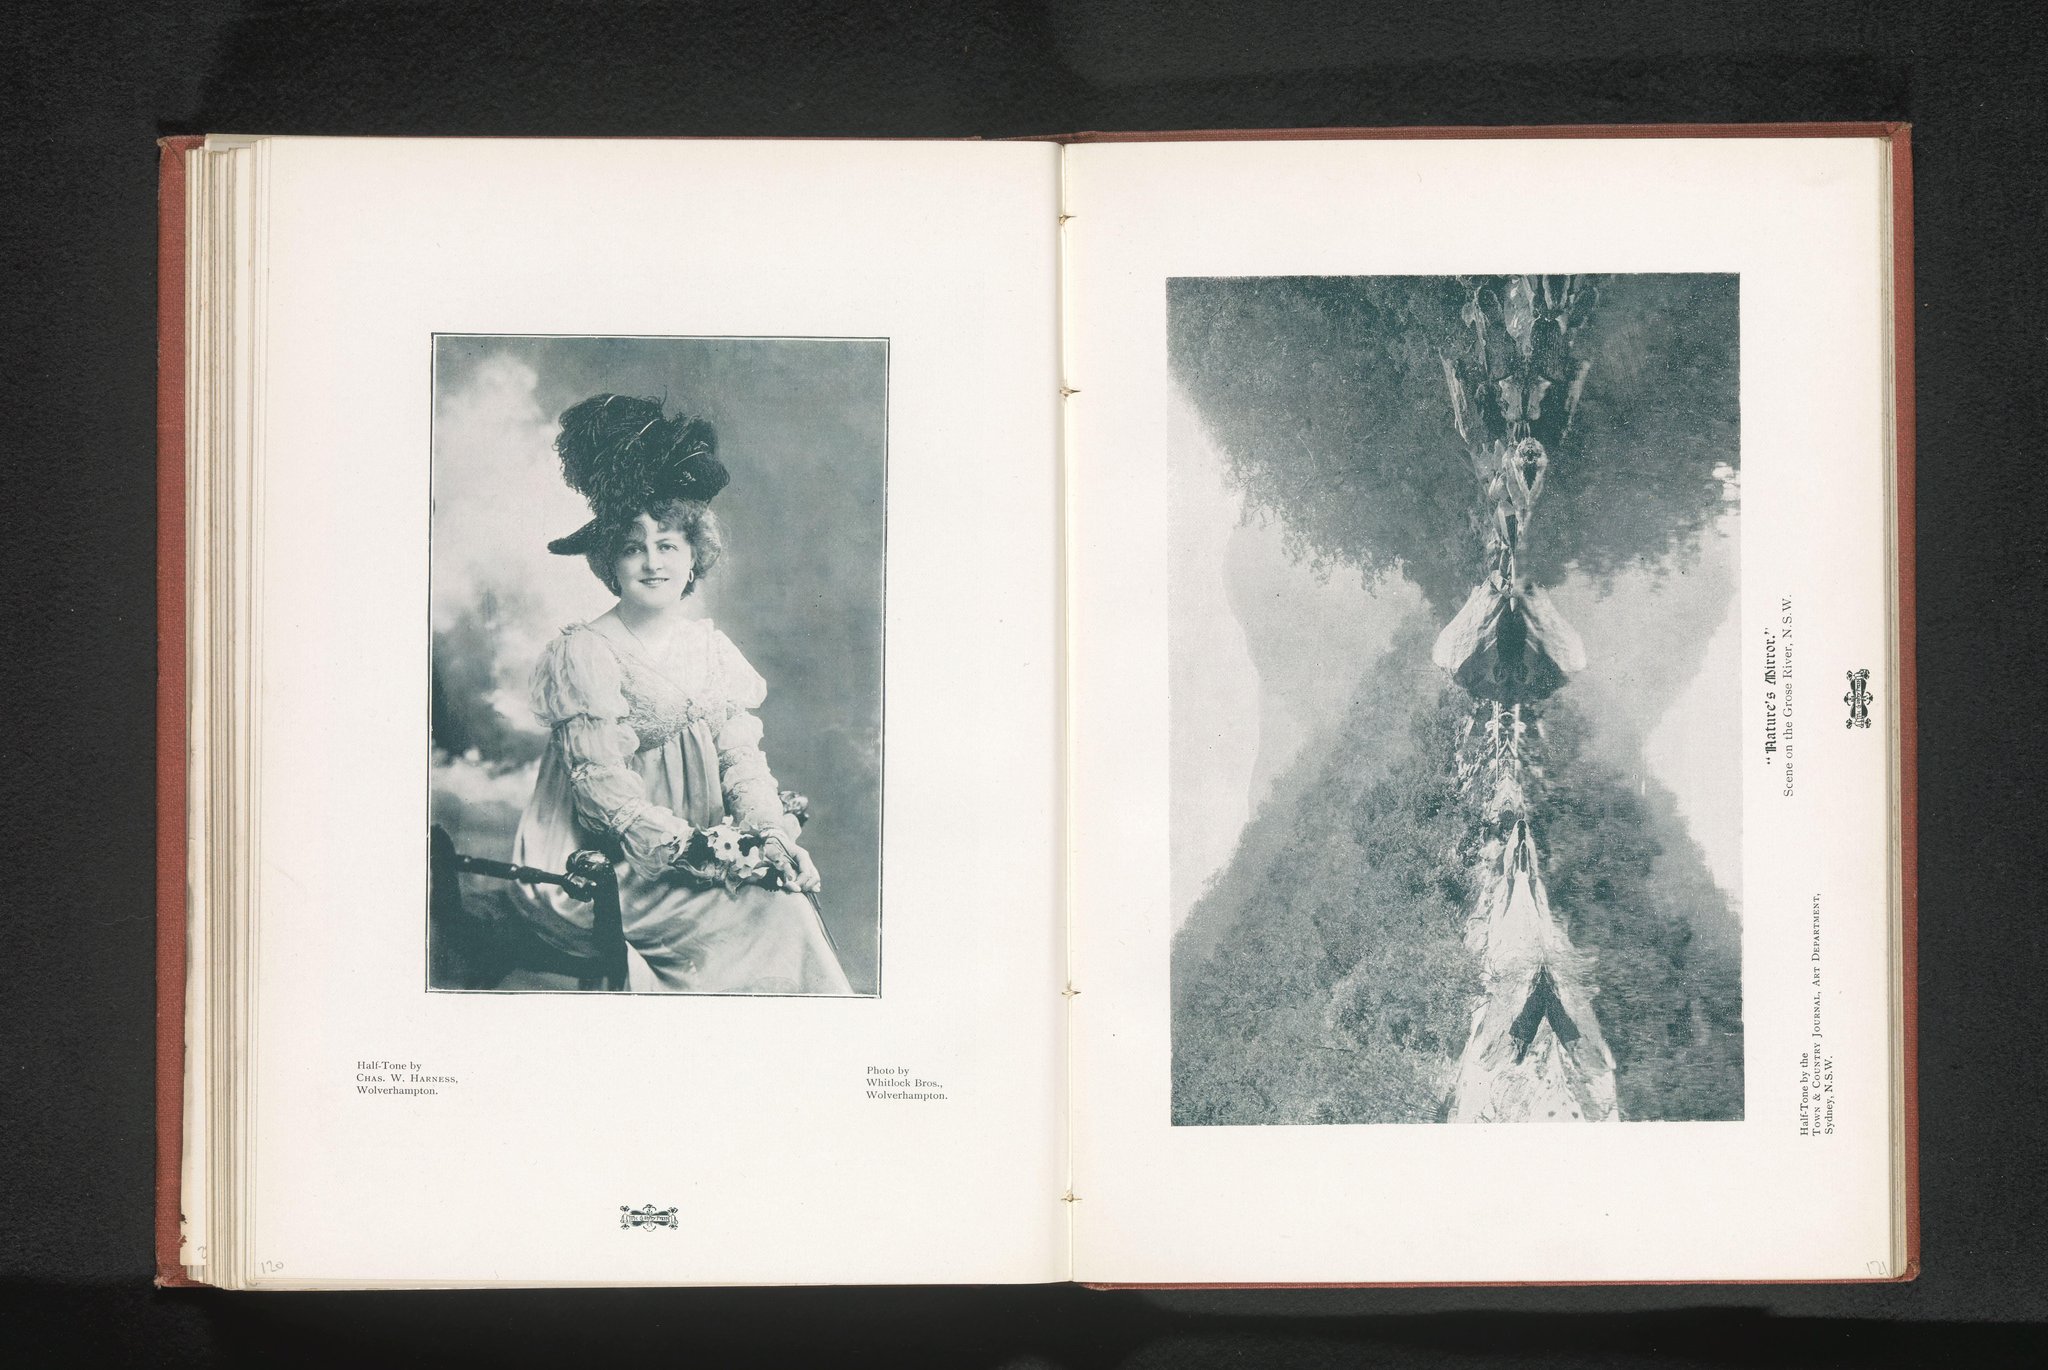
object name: page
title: Portret van een onbekende jonge vrouw met hoed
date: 1895-1900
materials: paper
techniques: autotype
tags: adolescent, young woman, maiden, historical persons - bb - woman, head-gear: hat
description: Prent op achtste ongenummerde pagina na pagina 96.